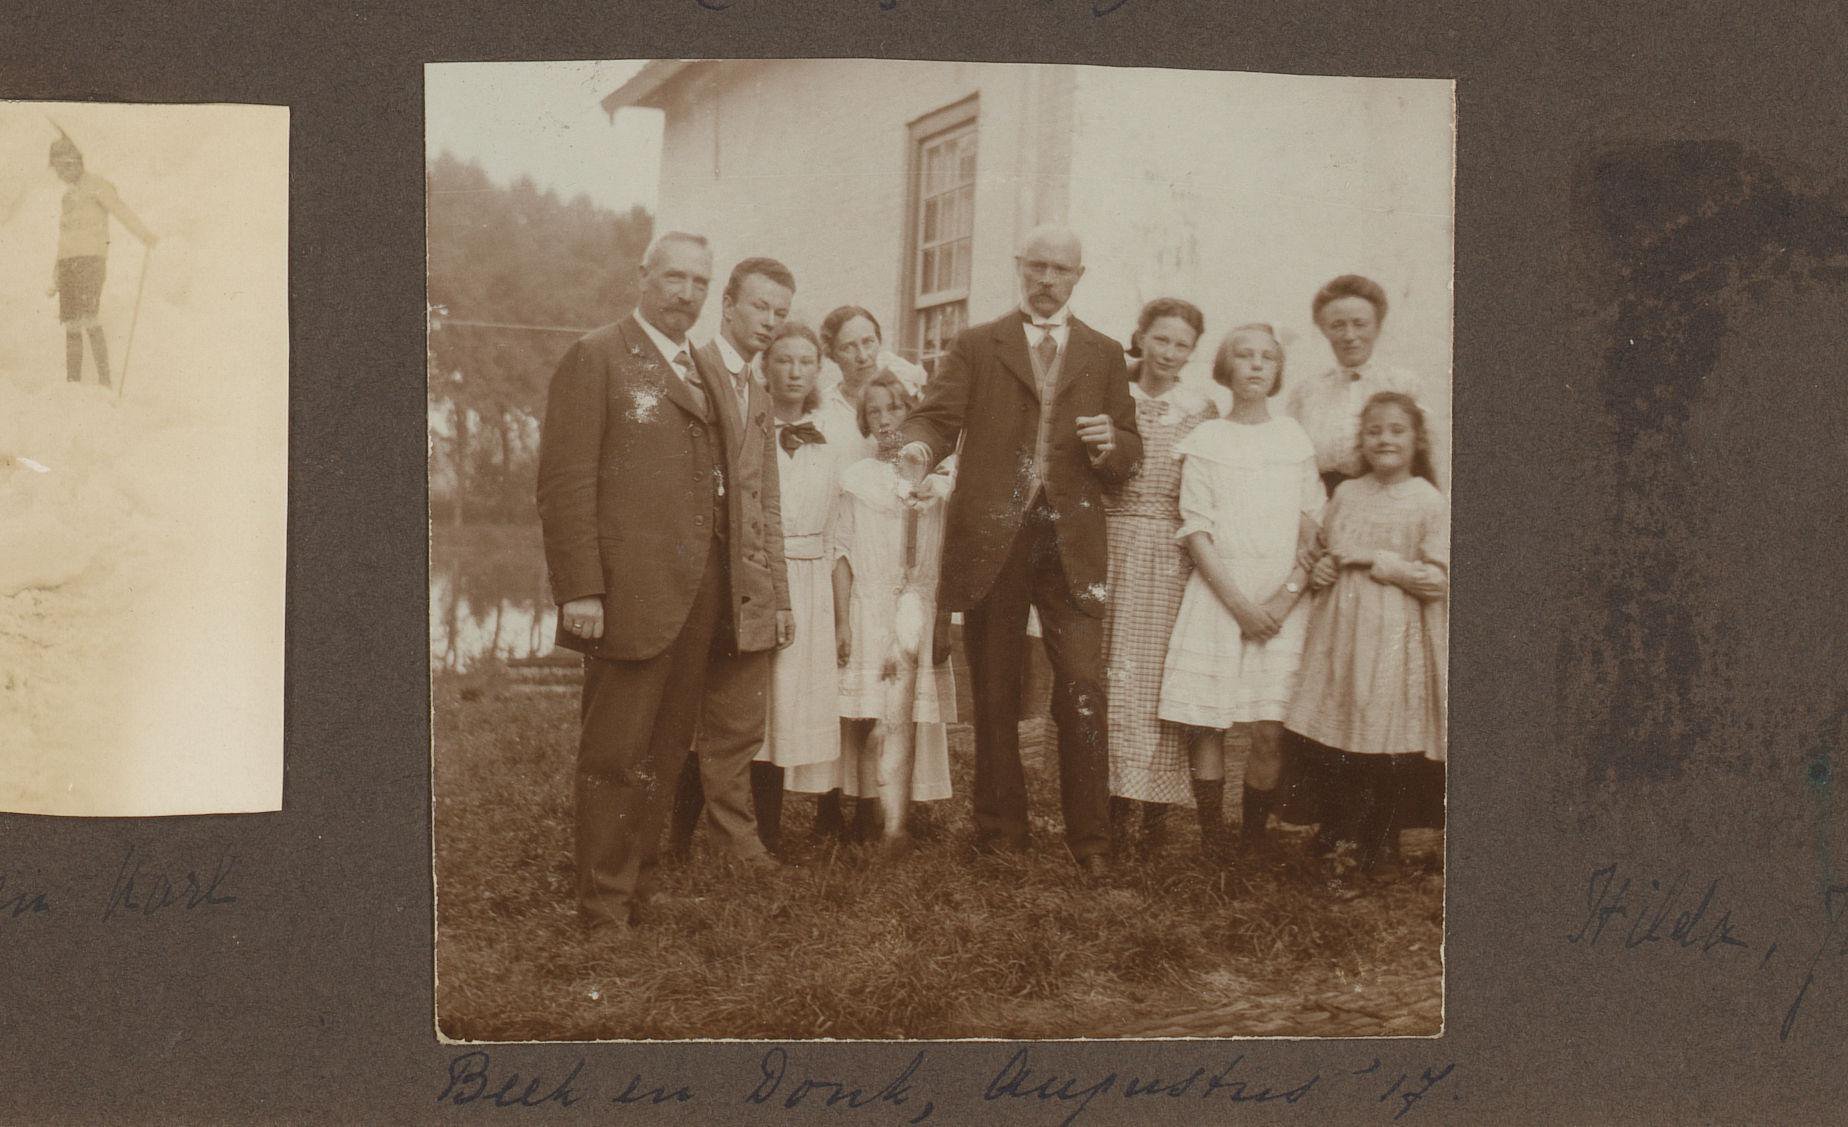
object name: photograph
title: Groepsportret in Beek en Donk, vermoedelijk familie De Jong van Beek en Donk bij kasteel Eikenlust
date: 1908-1917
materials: paper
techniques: collodion silver print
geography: beek en donk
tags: family relationships (first, second, third and fourth degree), generations, anonymous historical persons portrayed in a group, in a group-portrait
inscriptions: address and date: ‘Beek en Donk, Augustus '17’